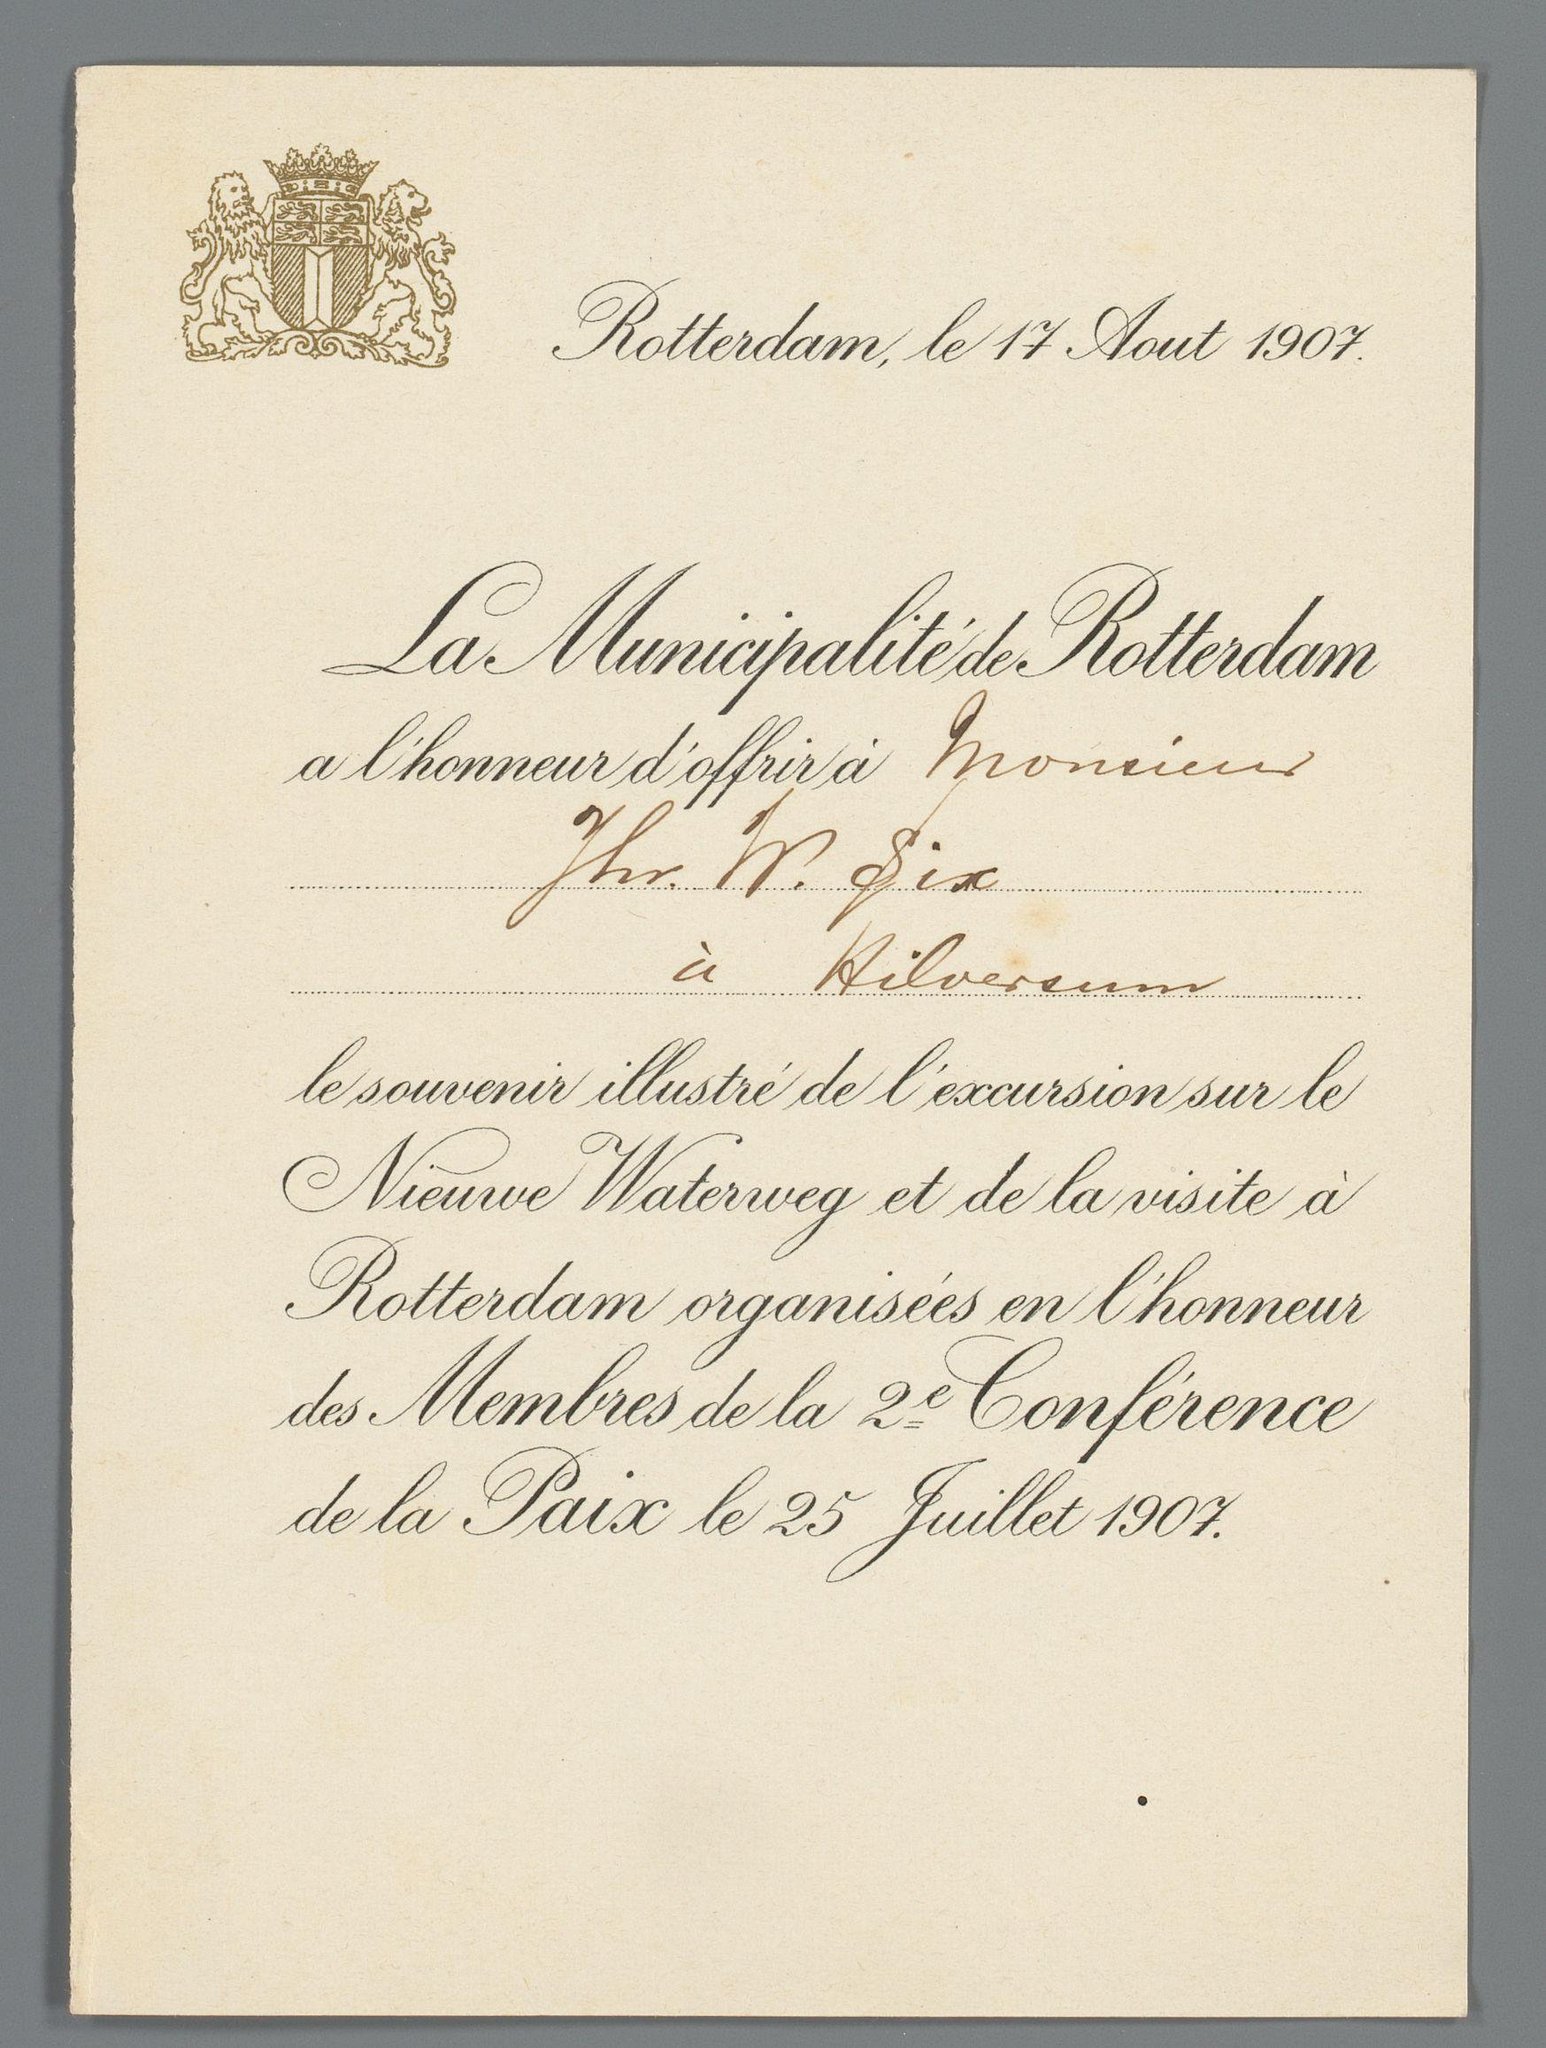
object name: photomechanical print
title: Begeleidende kaart bij een geschenk na een excursie naar de Nieuwe Waterweg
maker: Anonymous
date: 1907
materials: paper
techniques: printing block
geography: rotterdam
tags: coat of arms (as symbol of the state, etc.), fancy letters, rotterdam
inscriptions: date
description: Eenzijdige bedrukt blad met de tekst: 'Rotterdam, le 17 Aout 1907. La Municipalité de Rotterdam a l'honneur d'offrir á [monsieur Jhr. W. Six à Hilversum] le souvenir illustré de l'excursion sur le Nieuwe Waterweg et de la visite à Rotterdam organisées en l'honneur des Membres de la 2e Conférence de la Paix le 25 Juillet 1907' het gedeelte tussen rechte haken is met de hand geschreven). Linksboven het wapen van de stad Rotterdam (De Gemeente Rotterdam heeft de eer aan te bieden aan ... de geïllustreerde herinnering aan het bezoek aan de Nieuwe Waterweg en het bezoek aan Rotterdam georganiseerd voor de leden van de Haagse Vredesconferentie 1907).